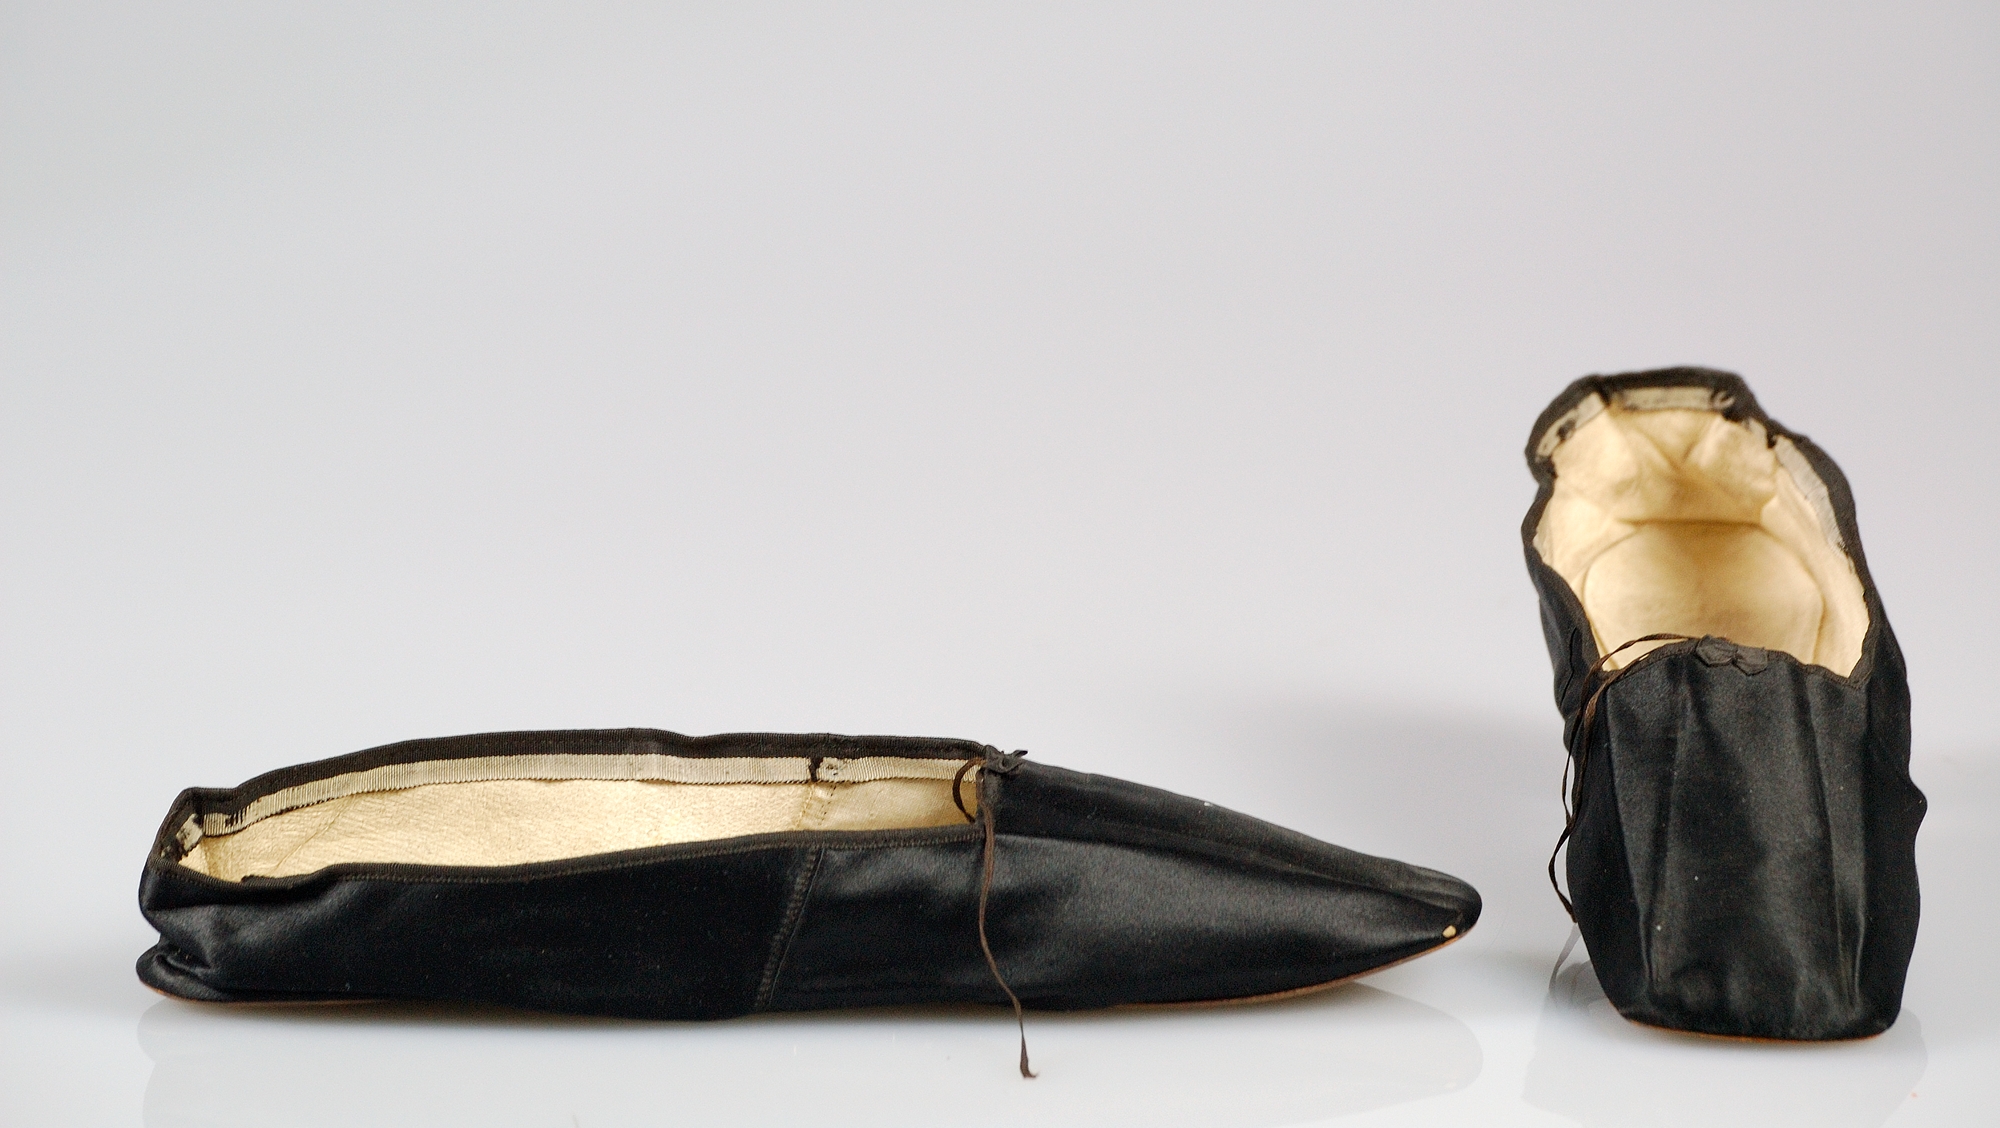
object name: evening slipper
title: Evening slippers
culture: french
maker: j. petit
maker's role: maker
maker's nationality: french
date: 1845-1865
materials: silk